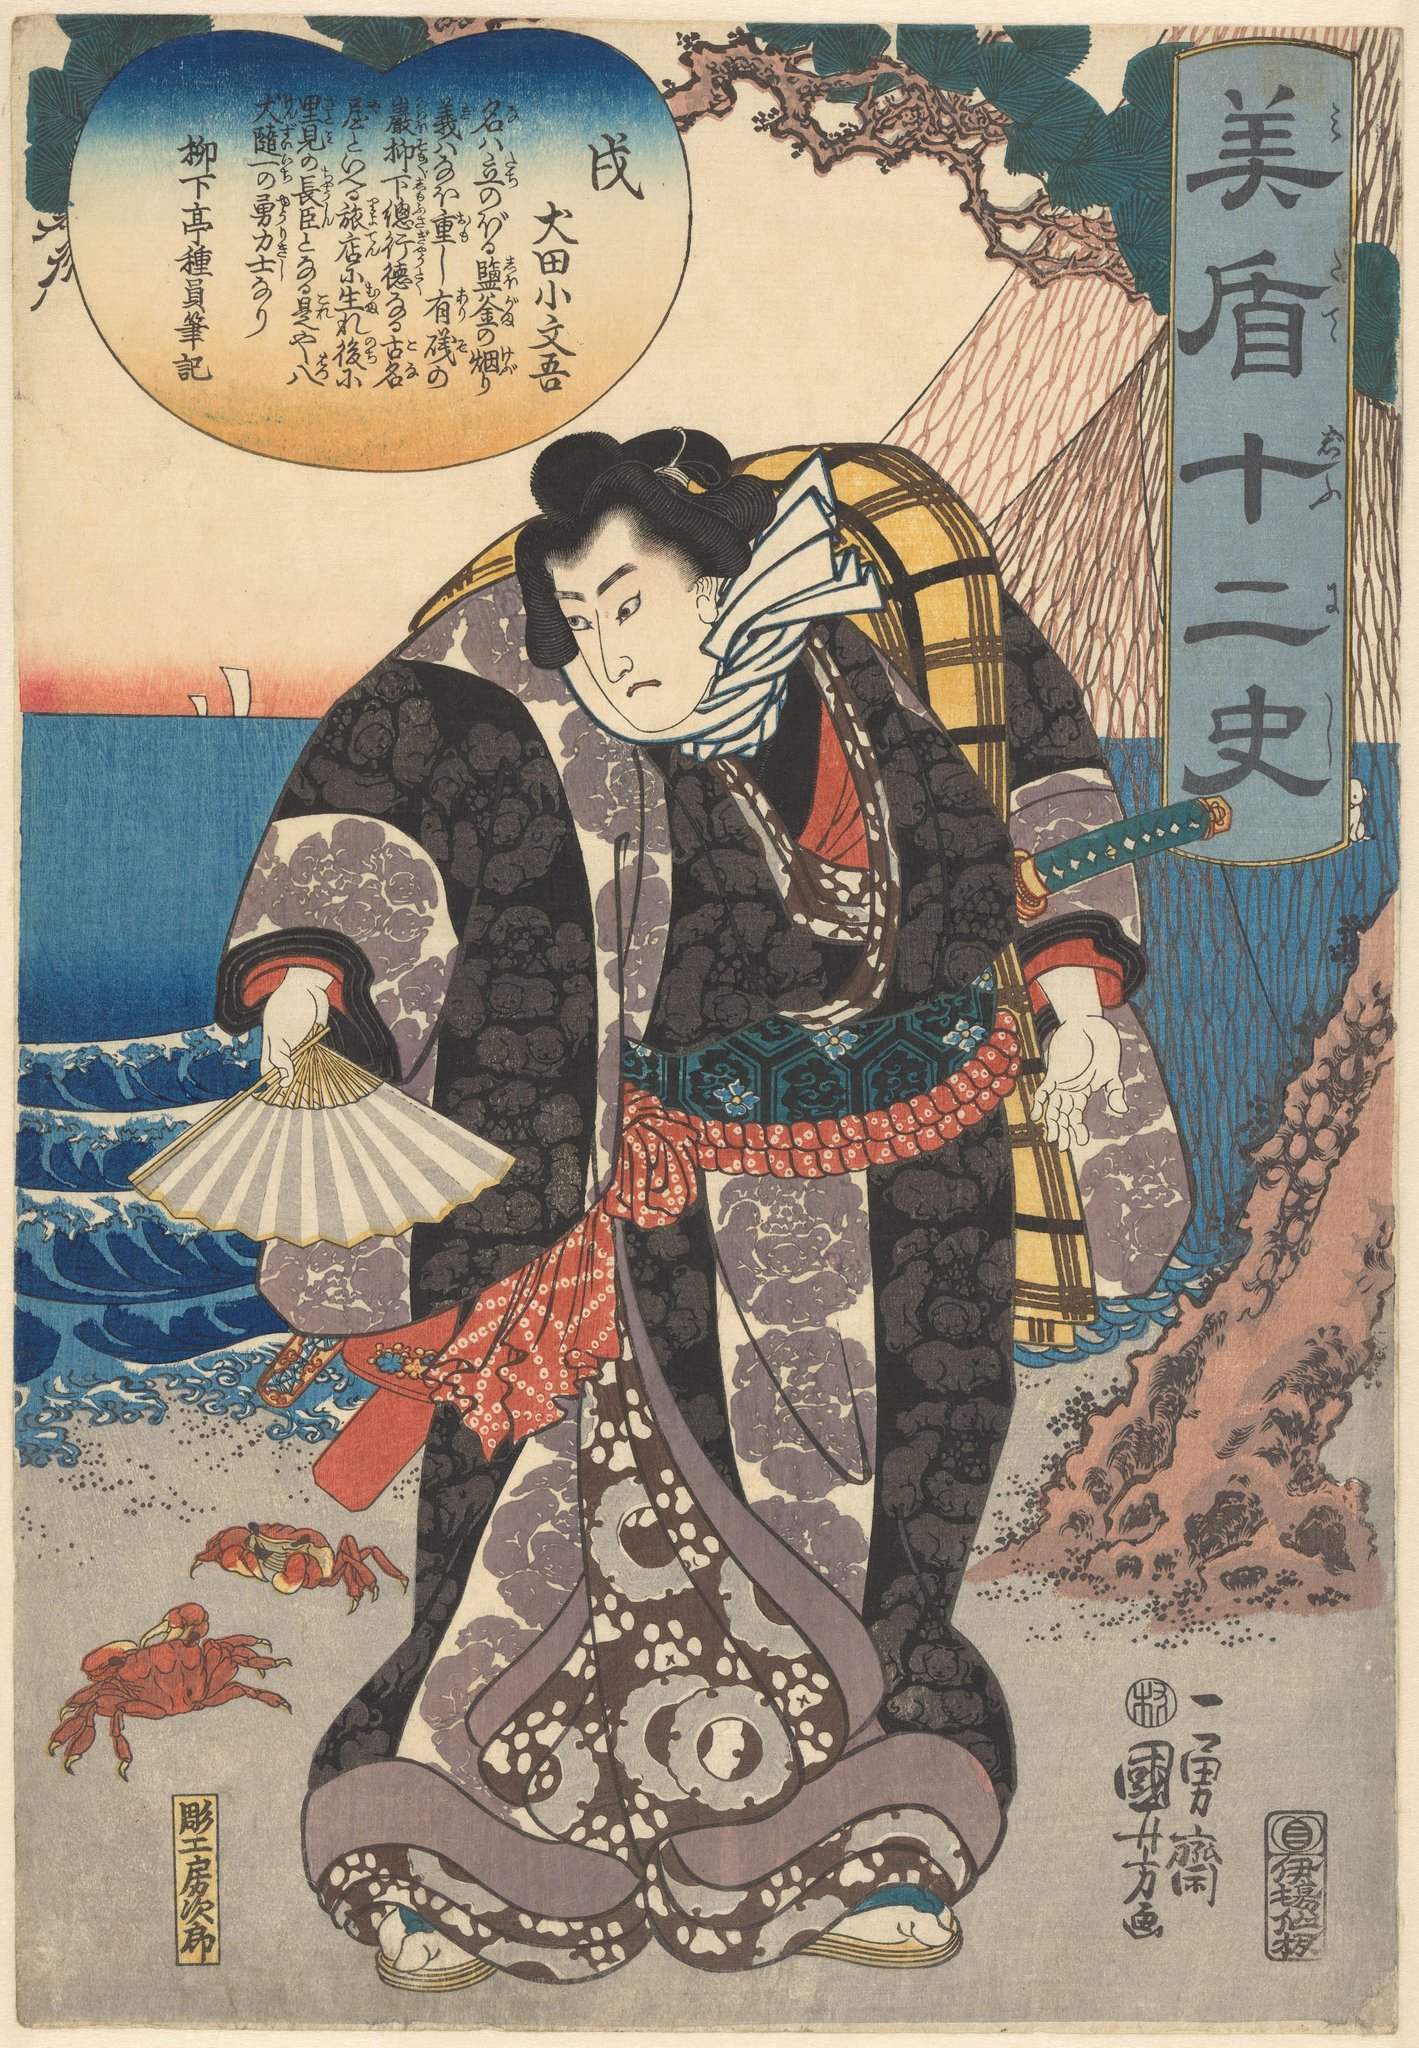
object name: print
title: Parallels with the twelve signs of the zodiac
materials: paper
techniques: woodcut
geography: japan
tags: adult man, crustaceans: crab, coast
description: Inuta Kobungo, één van de helden van de Hakkenden, is scheidsrechter op het strand in een wedstrijd tussen twee krabben. Op de achtergrond een pijnboom en drogende visnetten. Deze prent verbeeldt het dierenriemteken van de Hond, vanwege de Hakkenden (vertellingen van de Acht honden helden).